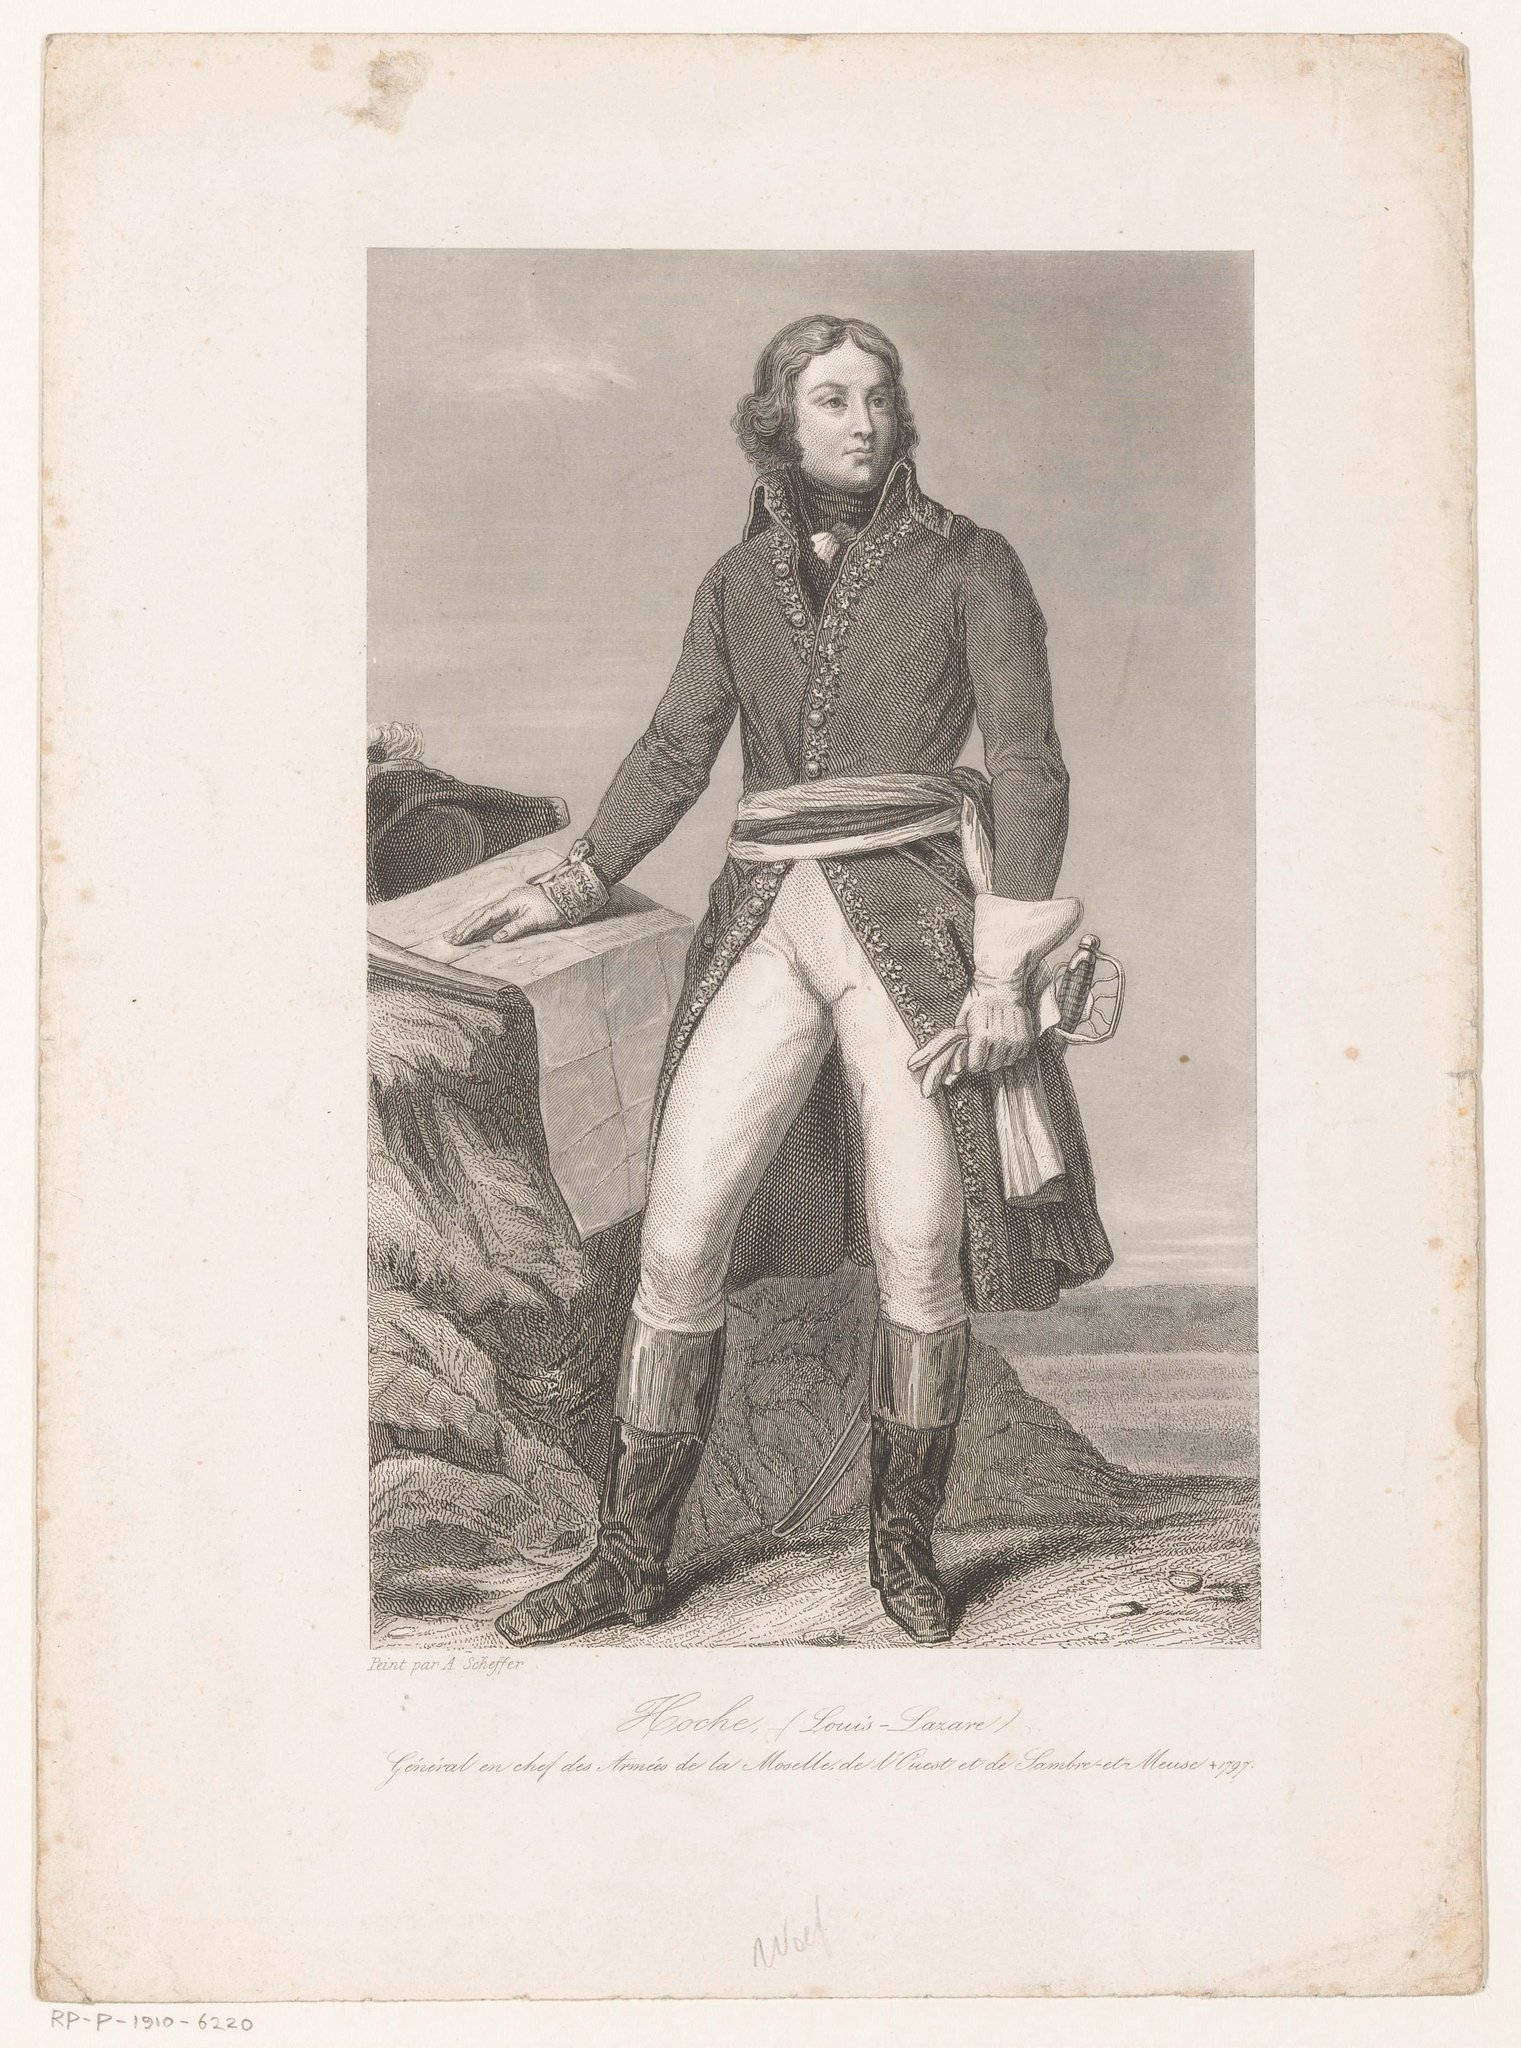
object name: print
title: Portret van Louis Lazare Hoche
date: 1838-1841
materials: paper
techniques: engraving, etching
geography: paris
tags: maps, atlases, commander-in-chief, general, marshal, historical persons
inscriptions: collector's mark: Lugt 2228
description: Prent uit: s.n. Galeries historiques de Versailles. Parijs: Charles Gavard, 1838-1841.